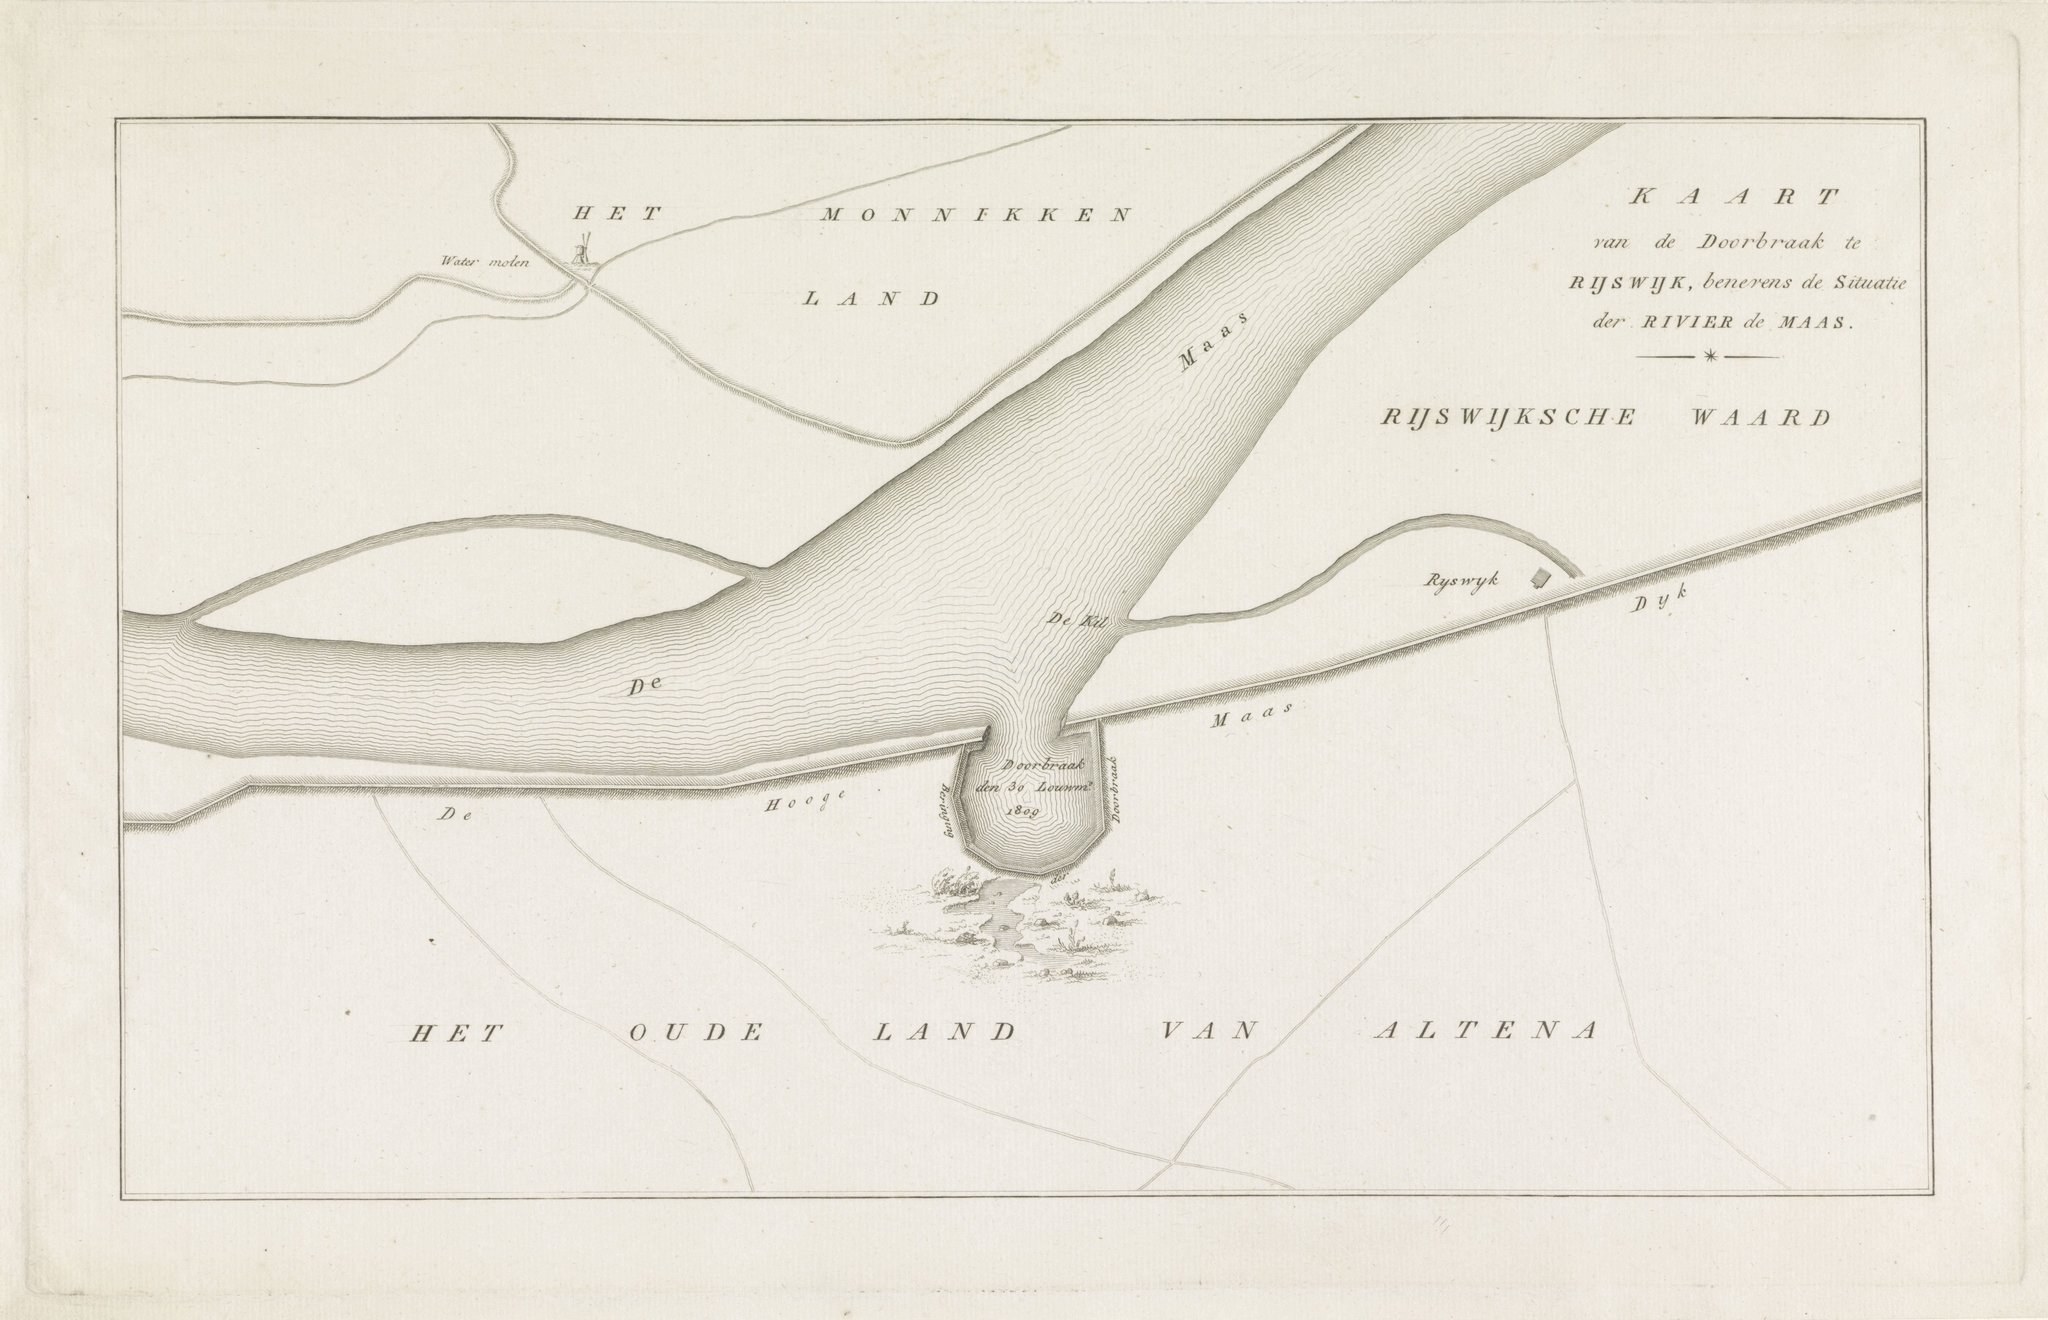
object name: print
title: Kaart van dijkdoorbraak te Rijswijk, 1809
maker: Anonymous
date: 1809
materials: paper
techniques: engraving, etching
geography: netherlands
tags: dike-break, maps of separate countries or regions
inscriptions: collector's mark: Lugt 2228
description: Gebruikt als illustratie in: Hendrik Ewijk. Geschiedkundig verslag der dijkbreuken en overstroomingen, langs de rivieren in het Koningrijk Holland, voorgevallen in louwmaand MDCCCIX. 3 dln. Amsterdam: Johannes Allart en Jacobus Ruys, 1809.